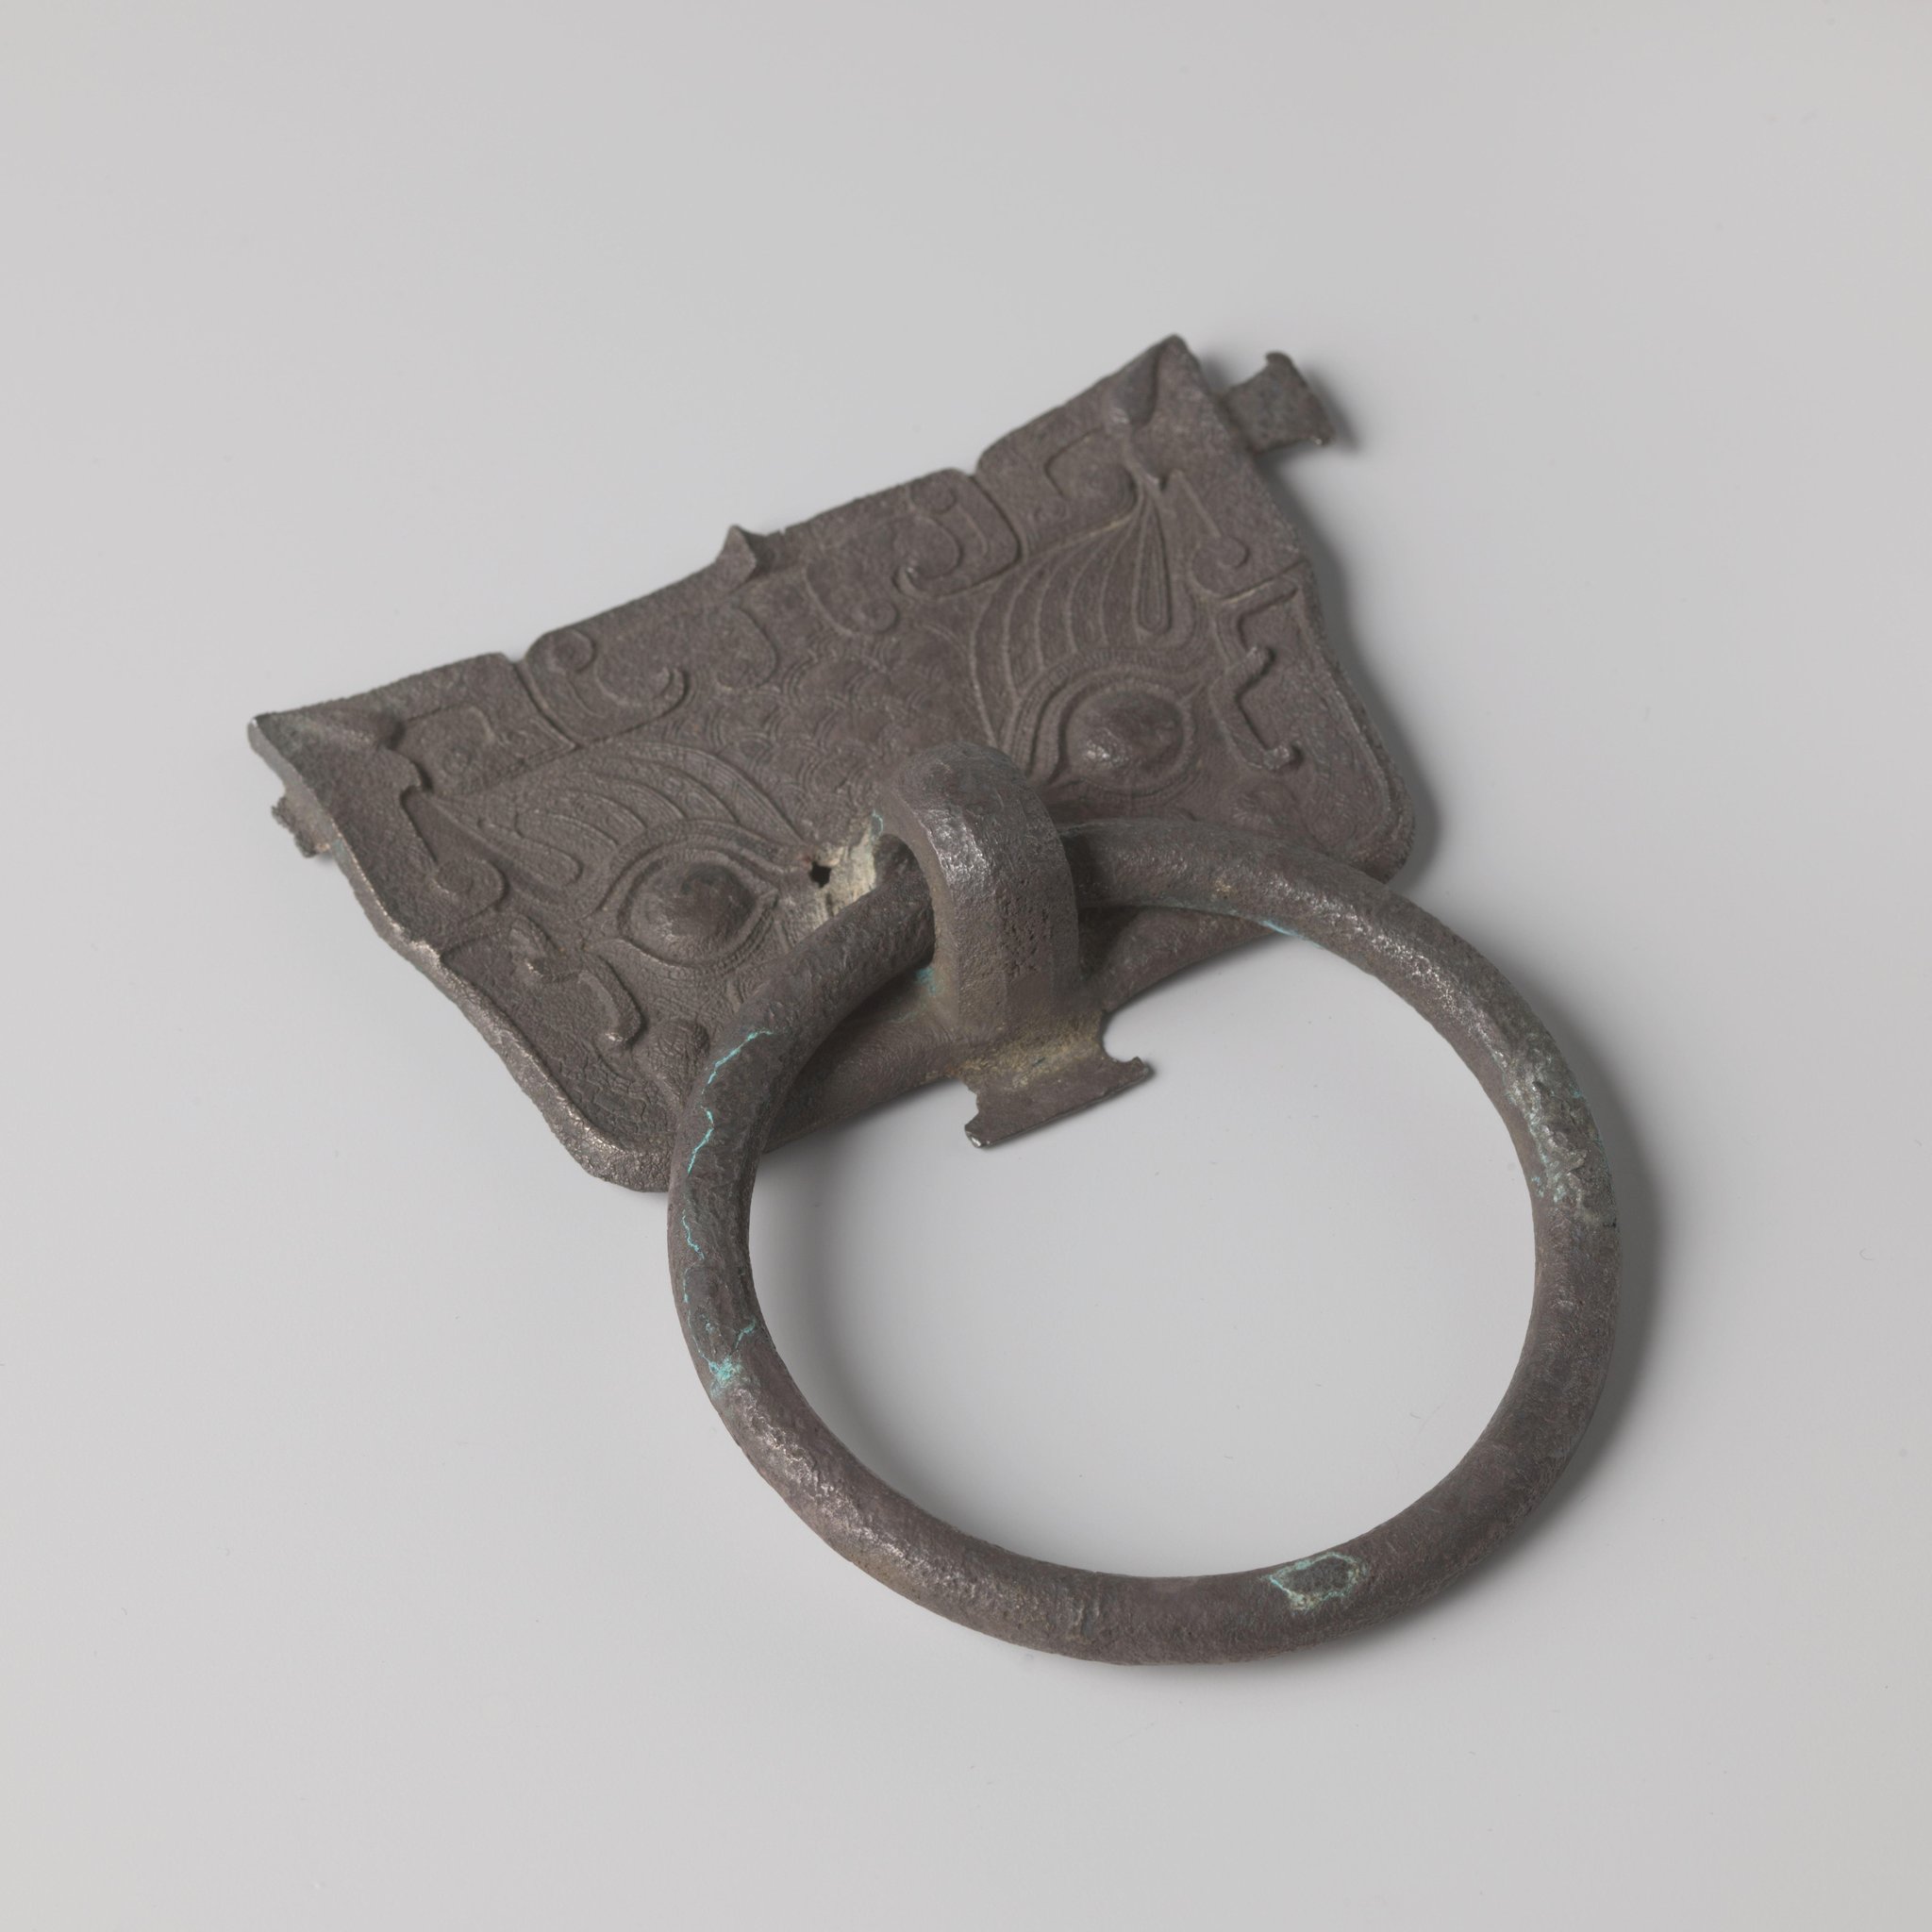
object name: hengsel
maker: Anonymous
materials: silver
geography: china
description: Two handles, decorated with taotie masks. China. Late Eastern Zhou period (481 - 222 BC). Silver. Given by E. Worch.